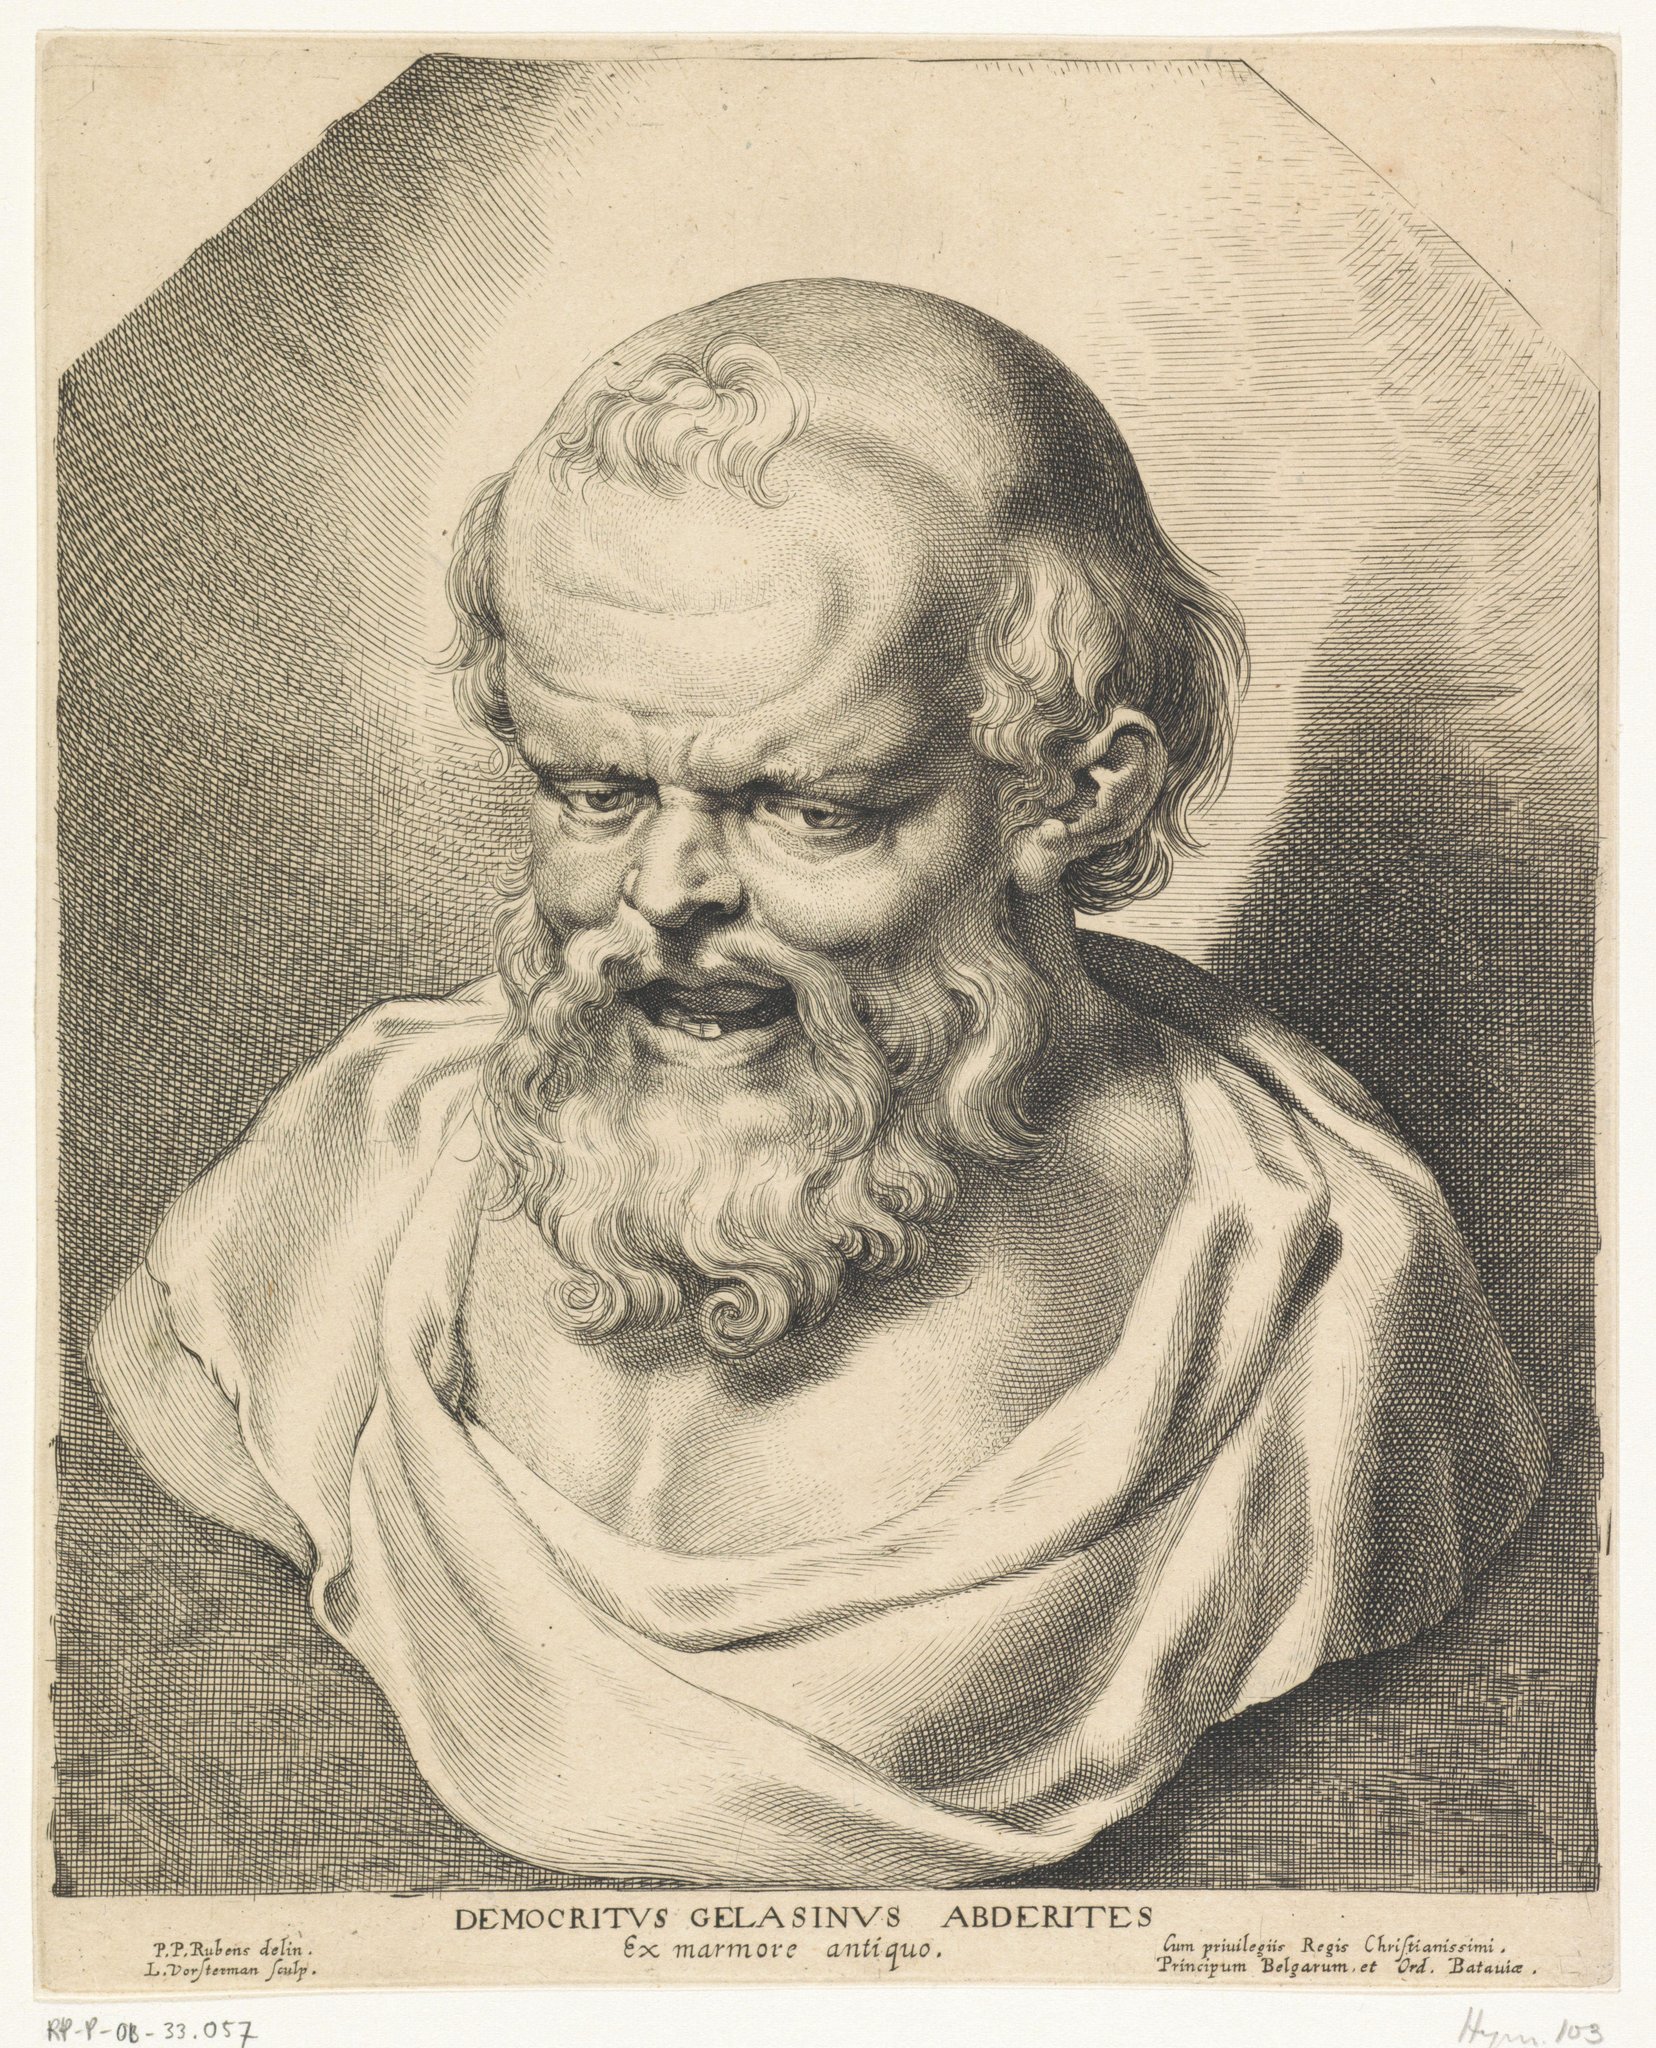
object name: print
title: Antieke bustes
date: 1630-1638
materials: paper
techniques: engraving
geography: antwerp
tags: piece of sculpture, reproduction of a piece of sculpture, (story of) democritus, the philosopher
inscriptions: collector's mark: Lugt 240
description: Buste van Democritus, de lachende filosoof. Prent uit een serie van twaalf prenten met antieke bustes, waarvan vier door Lucas Vorsterman I en acht door Boëtius Adamsz. Bolswert.